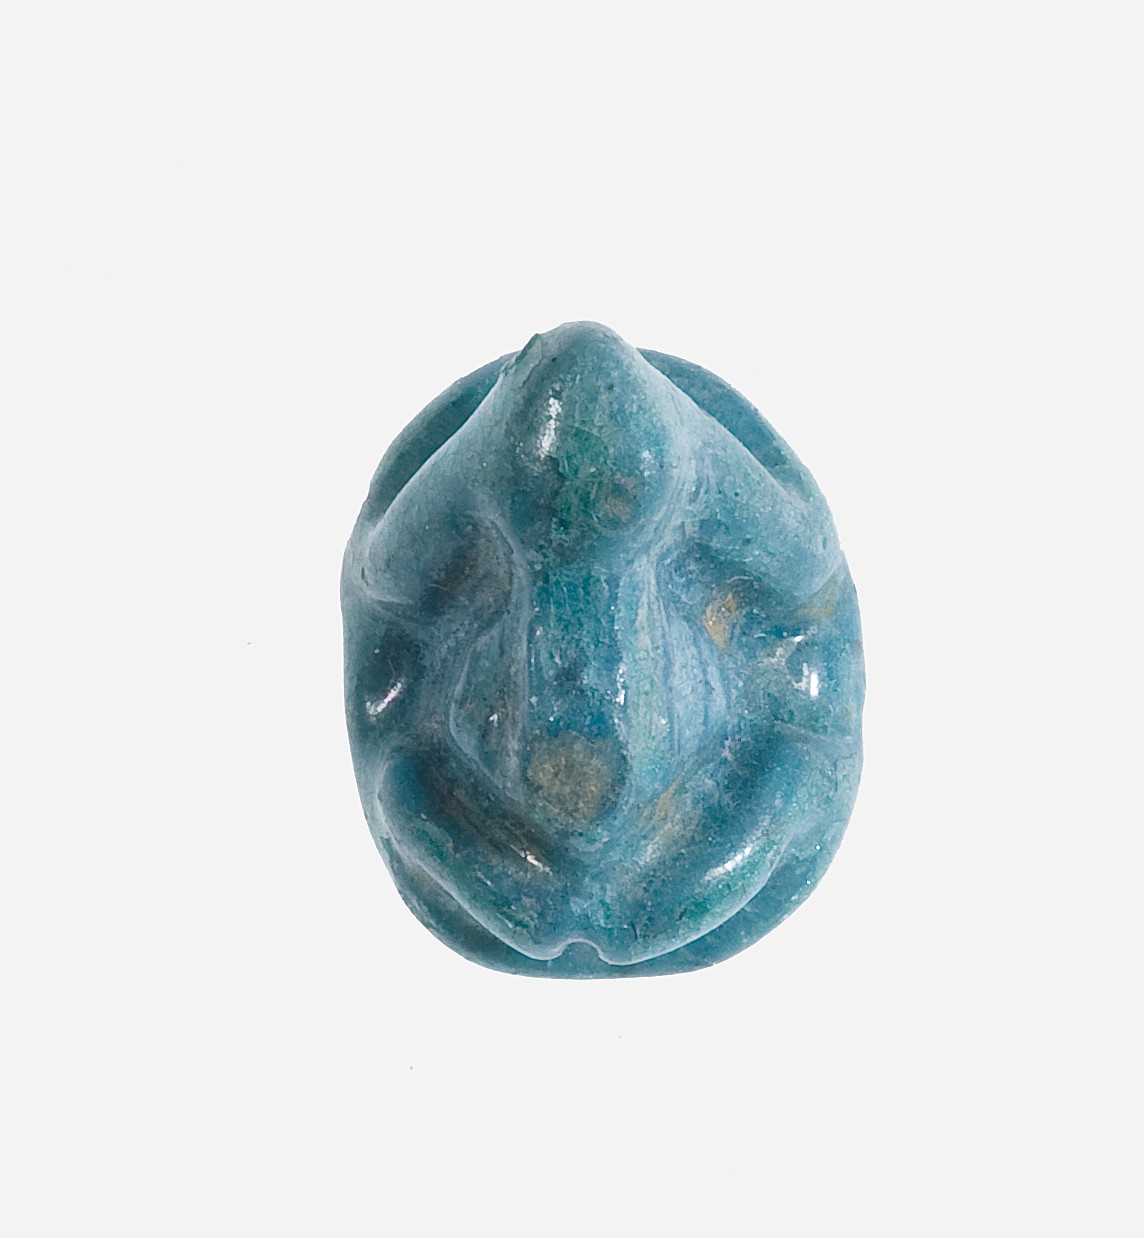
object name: seal amulet, frog, ankh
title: Frog Seal Amulet with an Ankh Hieroglyph on the Base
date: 1390-1352 BCE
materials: faience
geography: egypt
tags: hieroglyphs,frogs